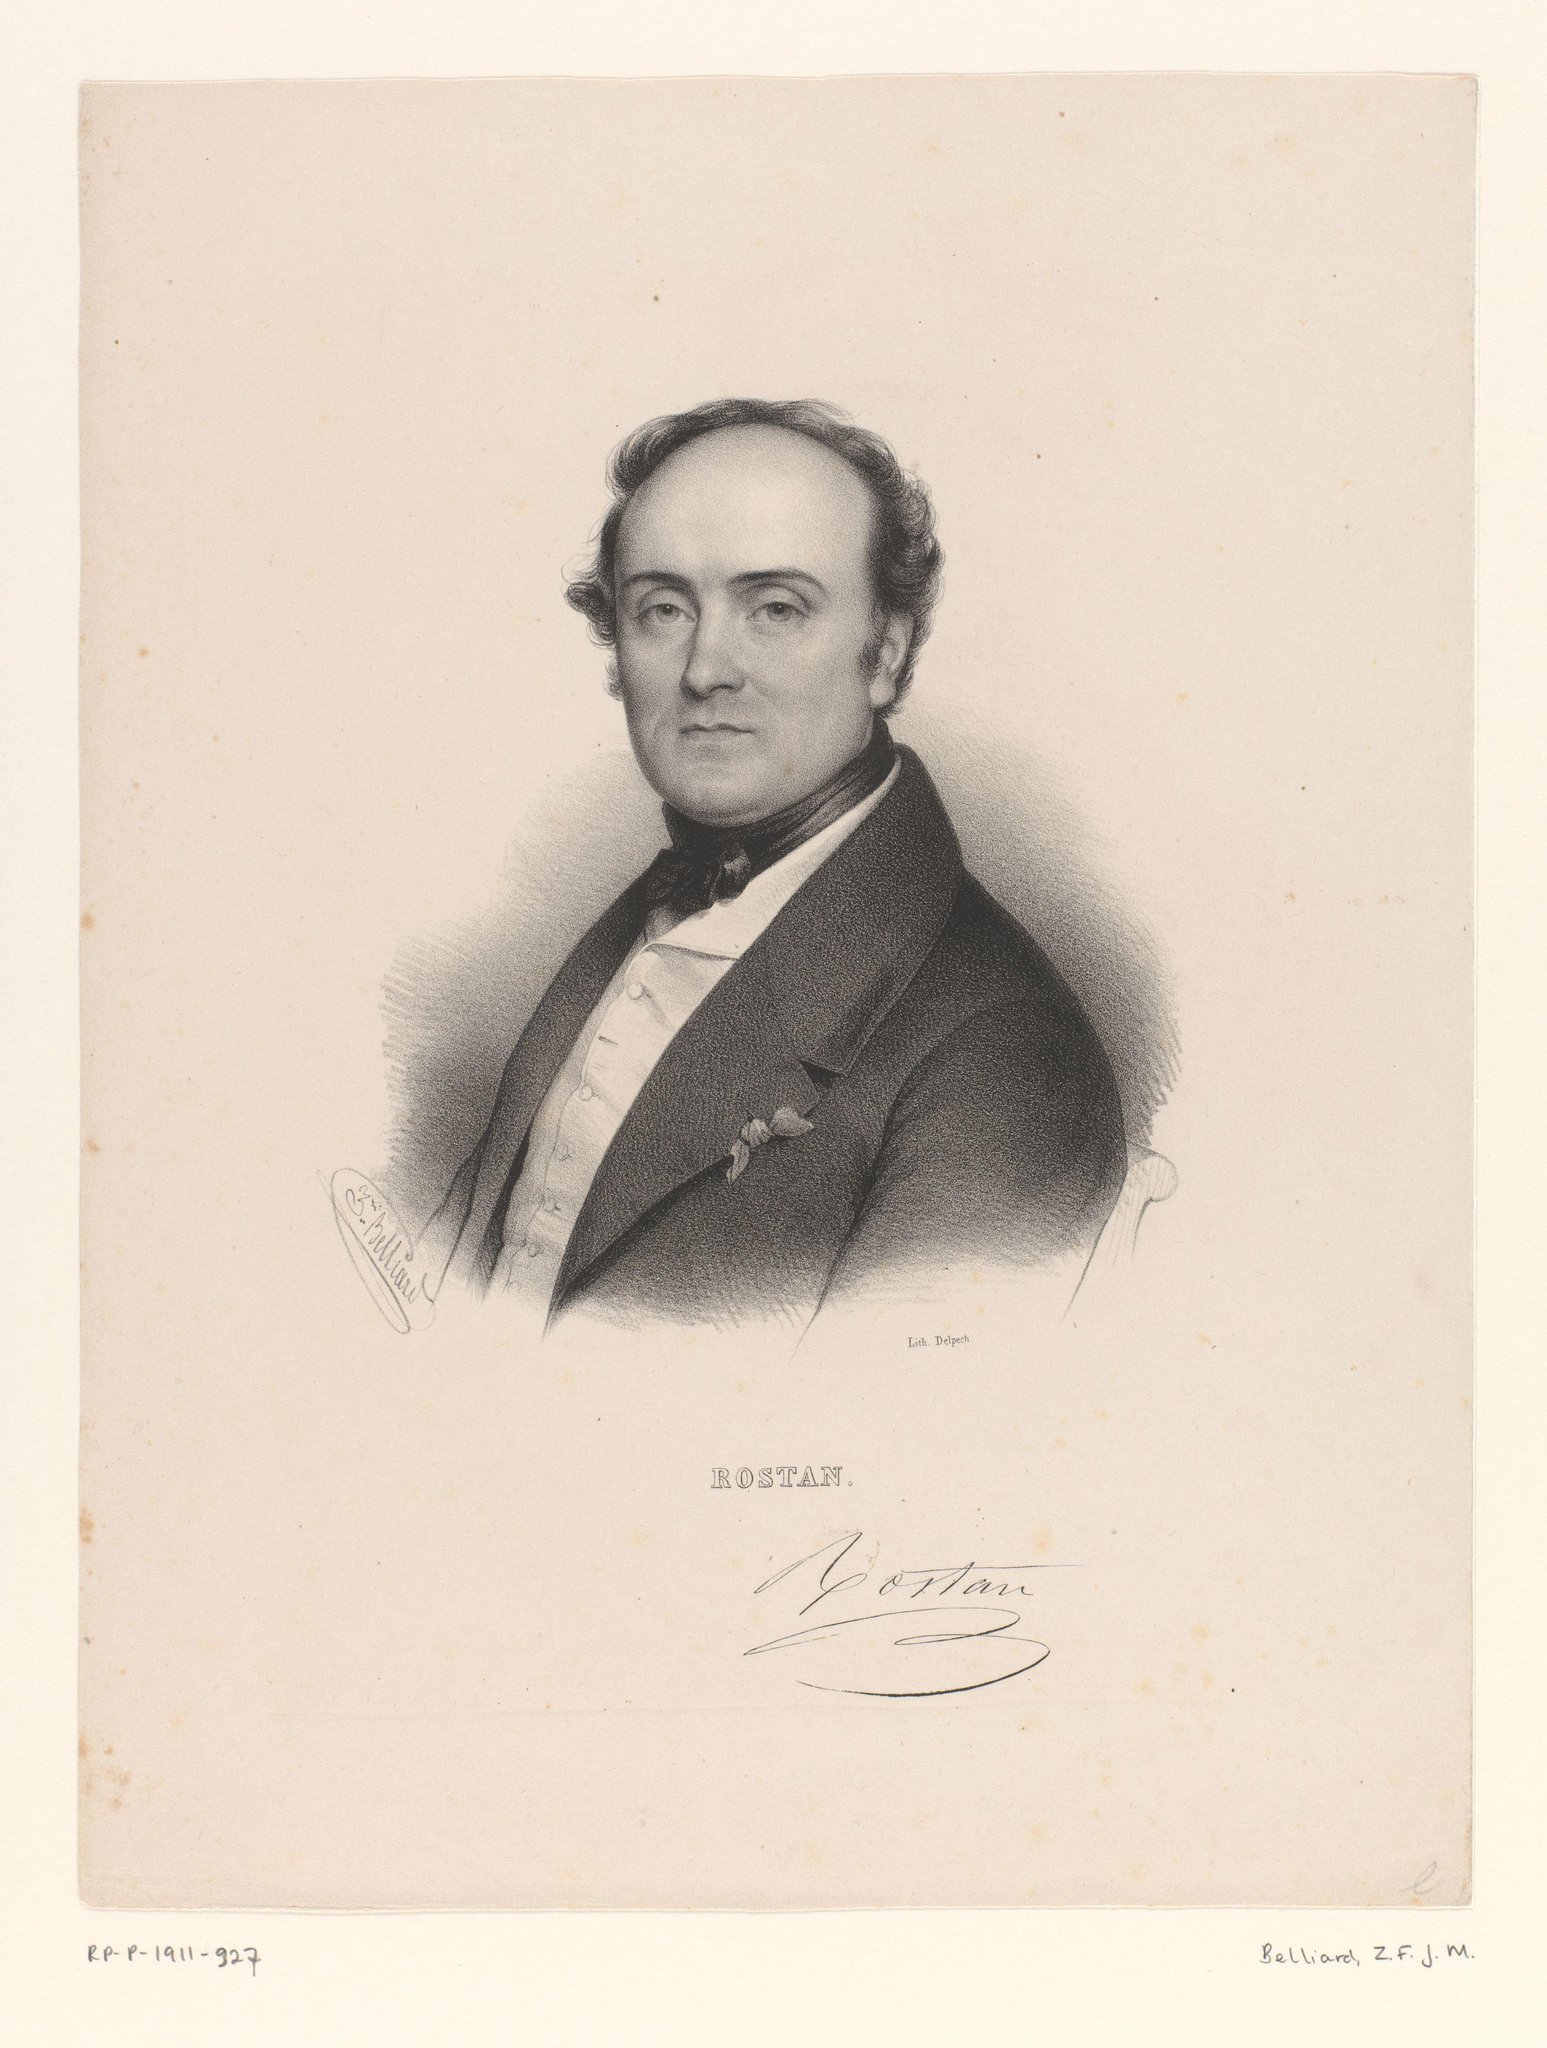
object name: print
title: Portretten van artsen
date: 1837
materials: paper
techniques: lithograph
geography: paris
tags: paris, historical persons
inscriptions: collector's mark: Lugt 2228a